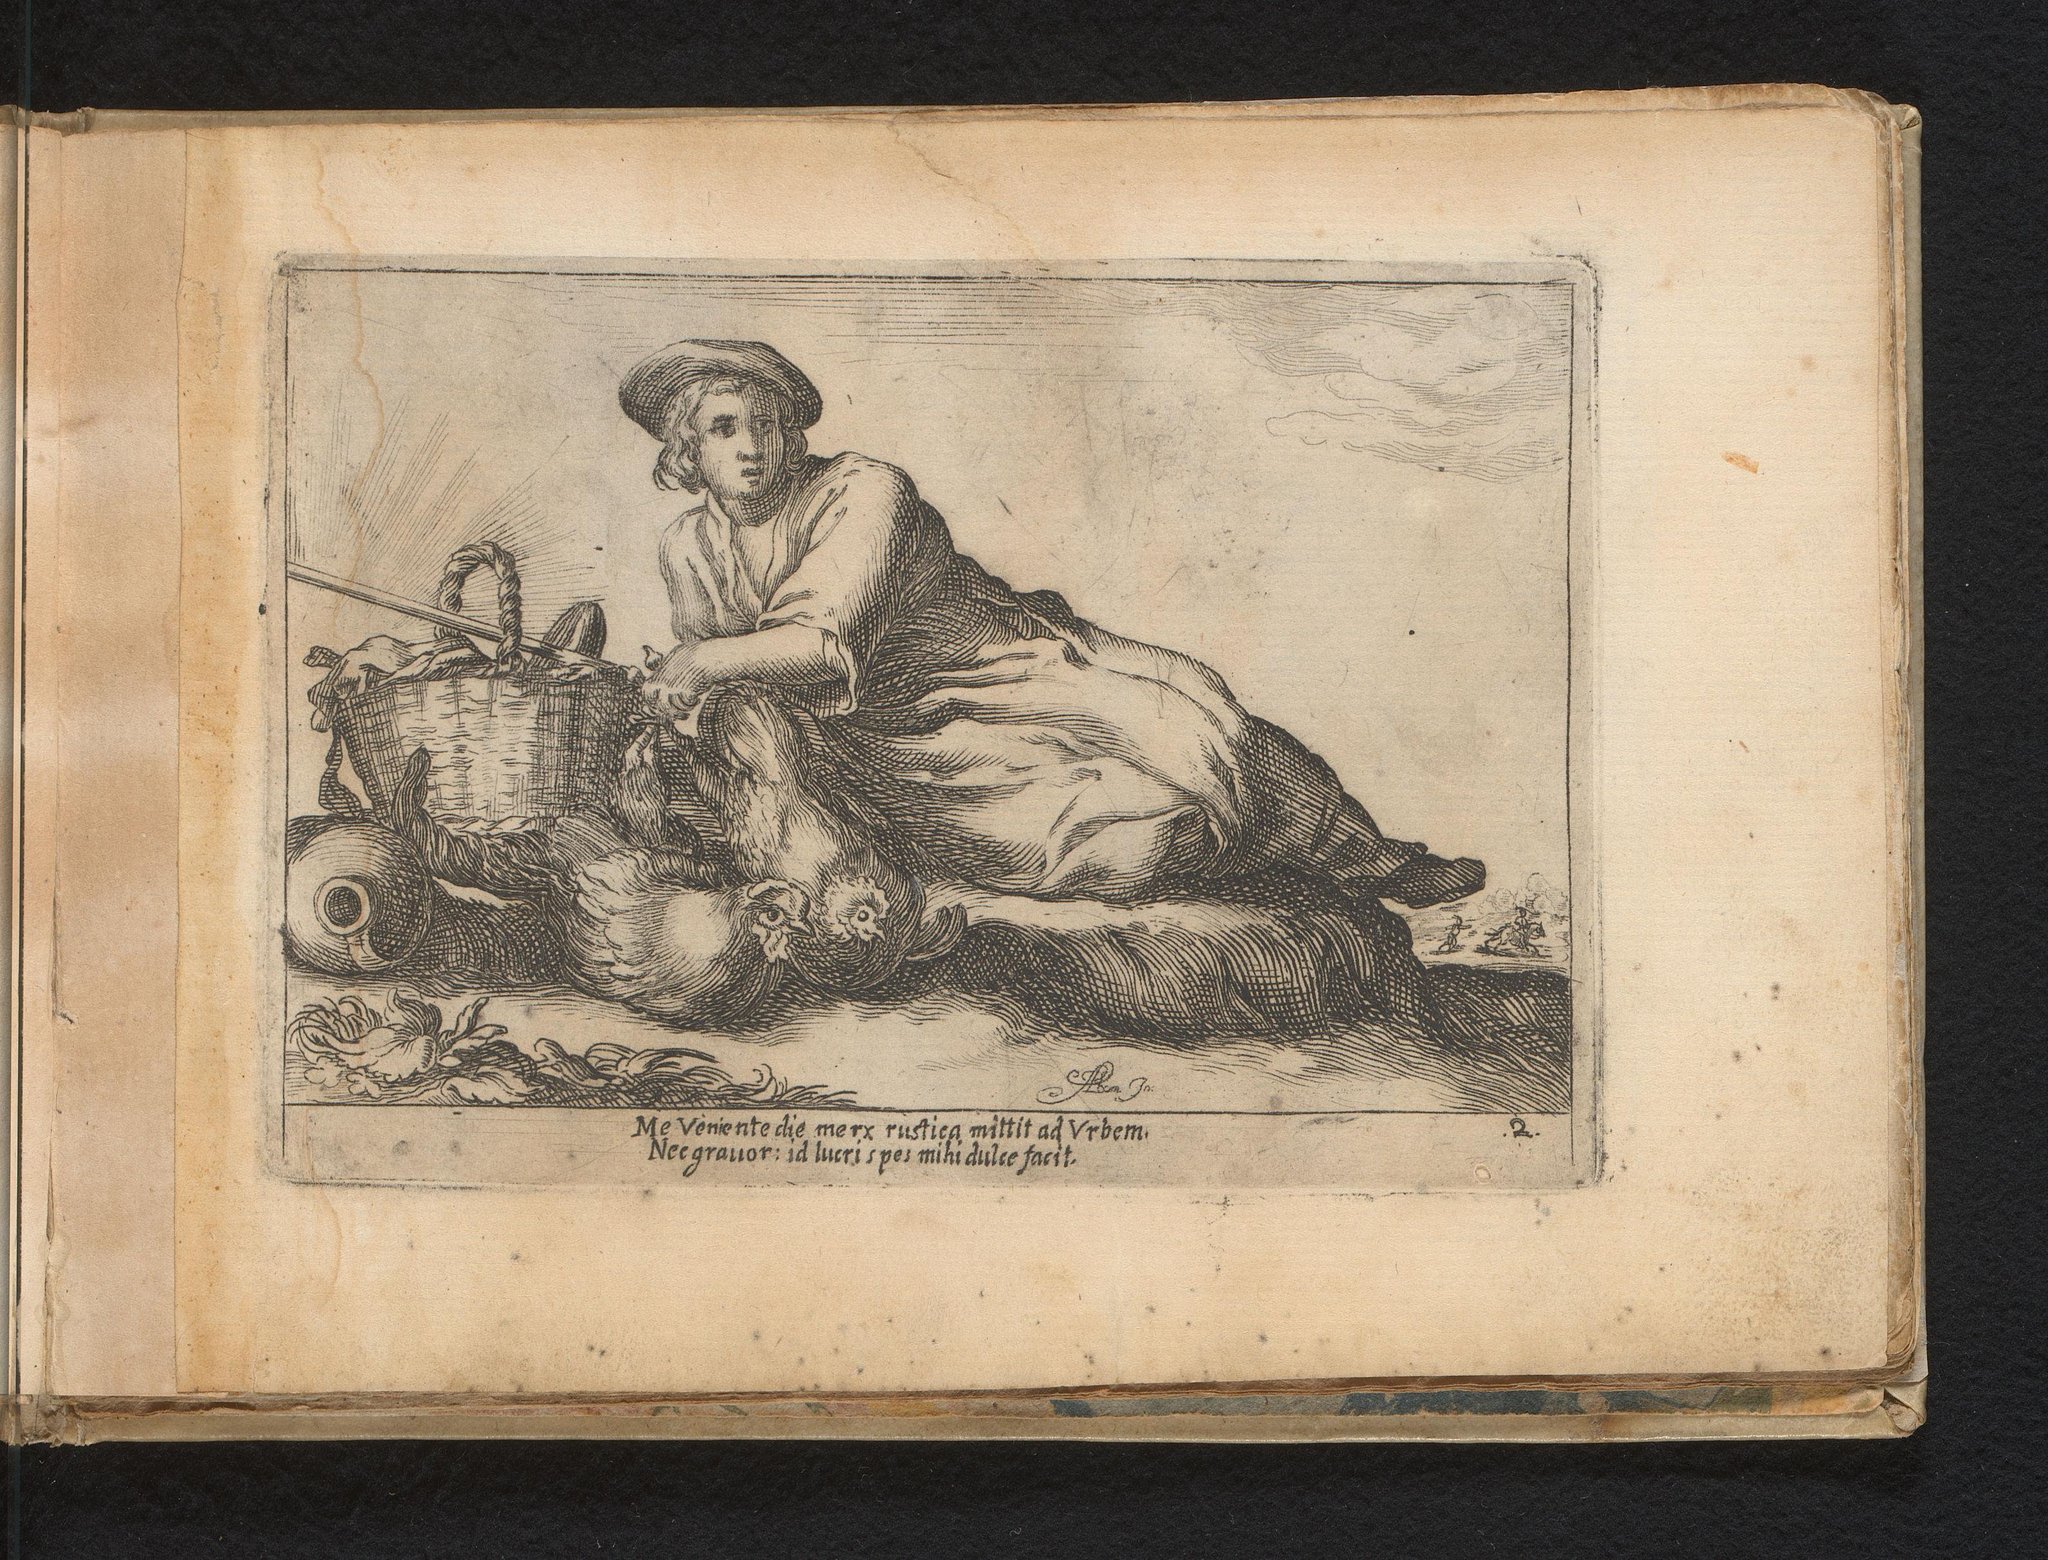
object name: print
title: Liggende vrouw met kippen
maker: Anonymous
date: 1629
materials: ink, paper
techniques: engraving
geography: utrecht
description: Een vrouw ligt te rusten met een mand en twee kippen naast haar. Met tweeregelig vers in het Latijn in ondermarge. Prent uit album met een serie van 16 ingebonden prenten met pastorale scènes. Het betreft de serie getiteld: Otia delectant faciuntq [...]. Kalfsleren band met opschrift en decoratieve kaderlijnen in pen in bruin. Voorin en achterin vier schutbladen van velijn.